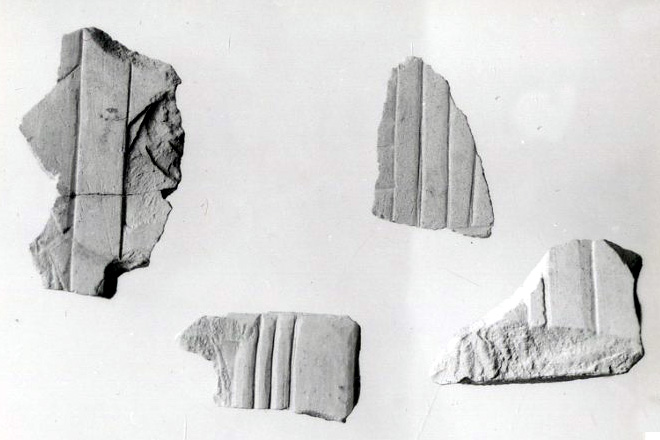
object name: relief fragment, tomb of meketre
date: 1981-1975 BCE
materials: limestone, paint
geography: egypt